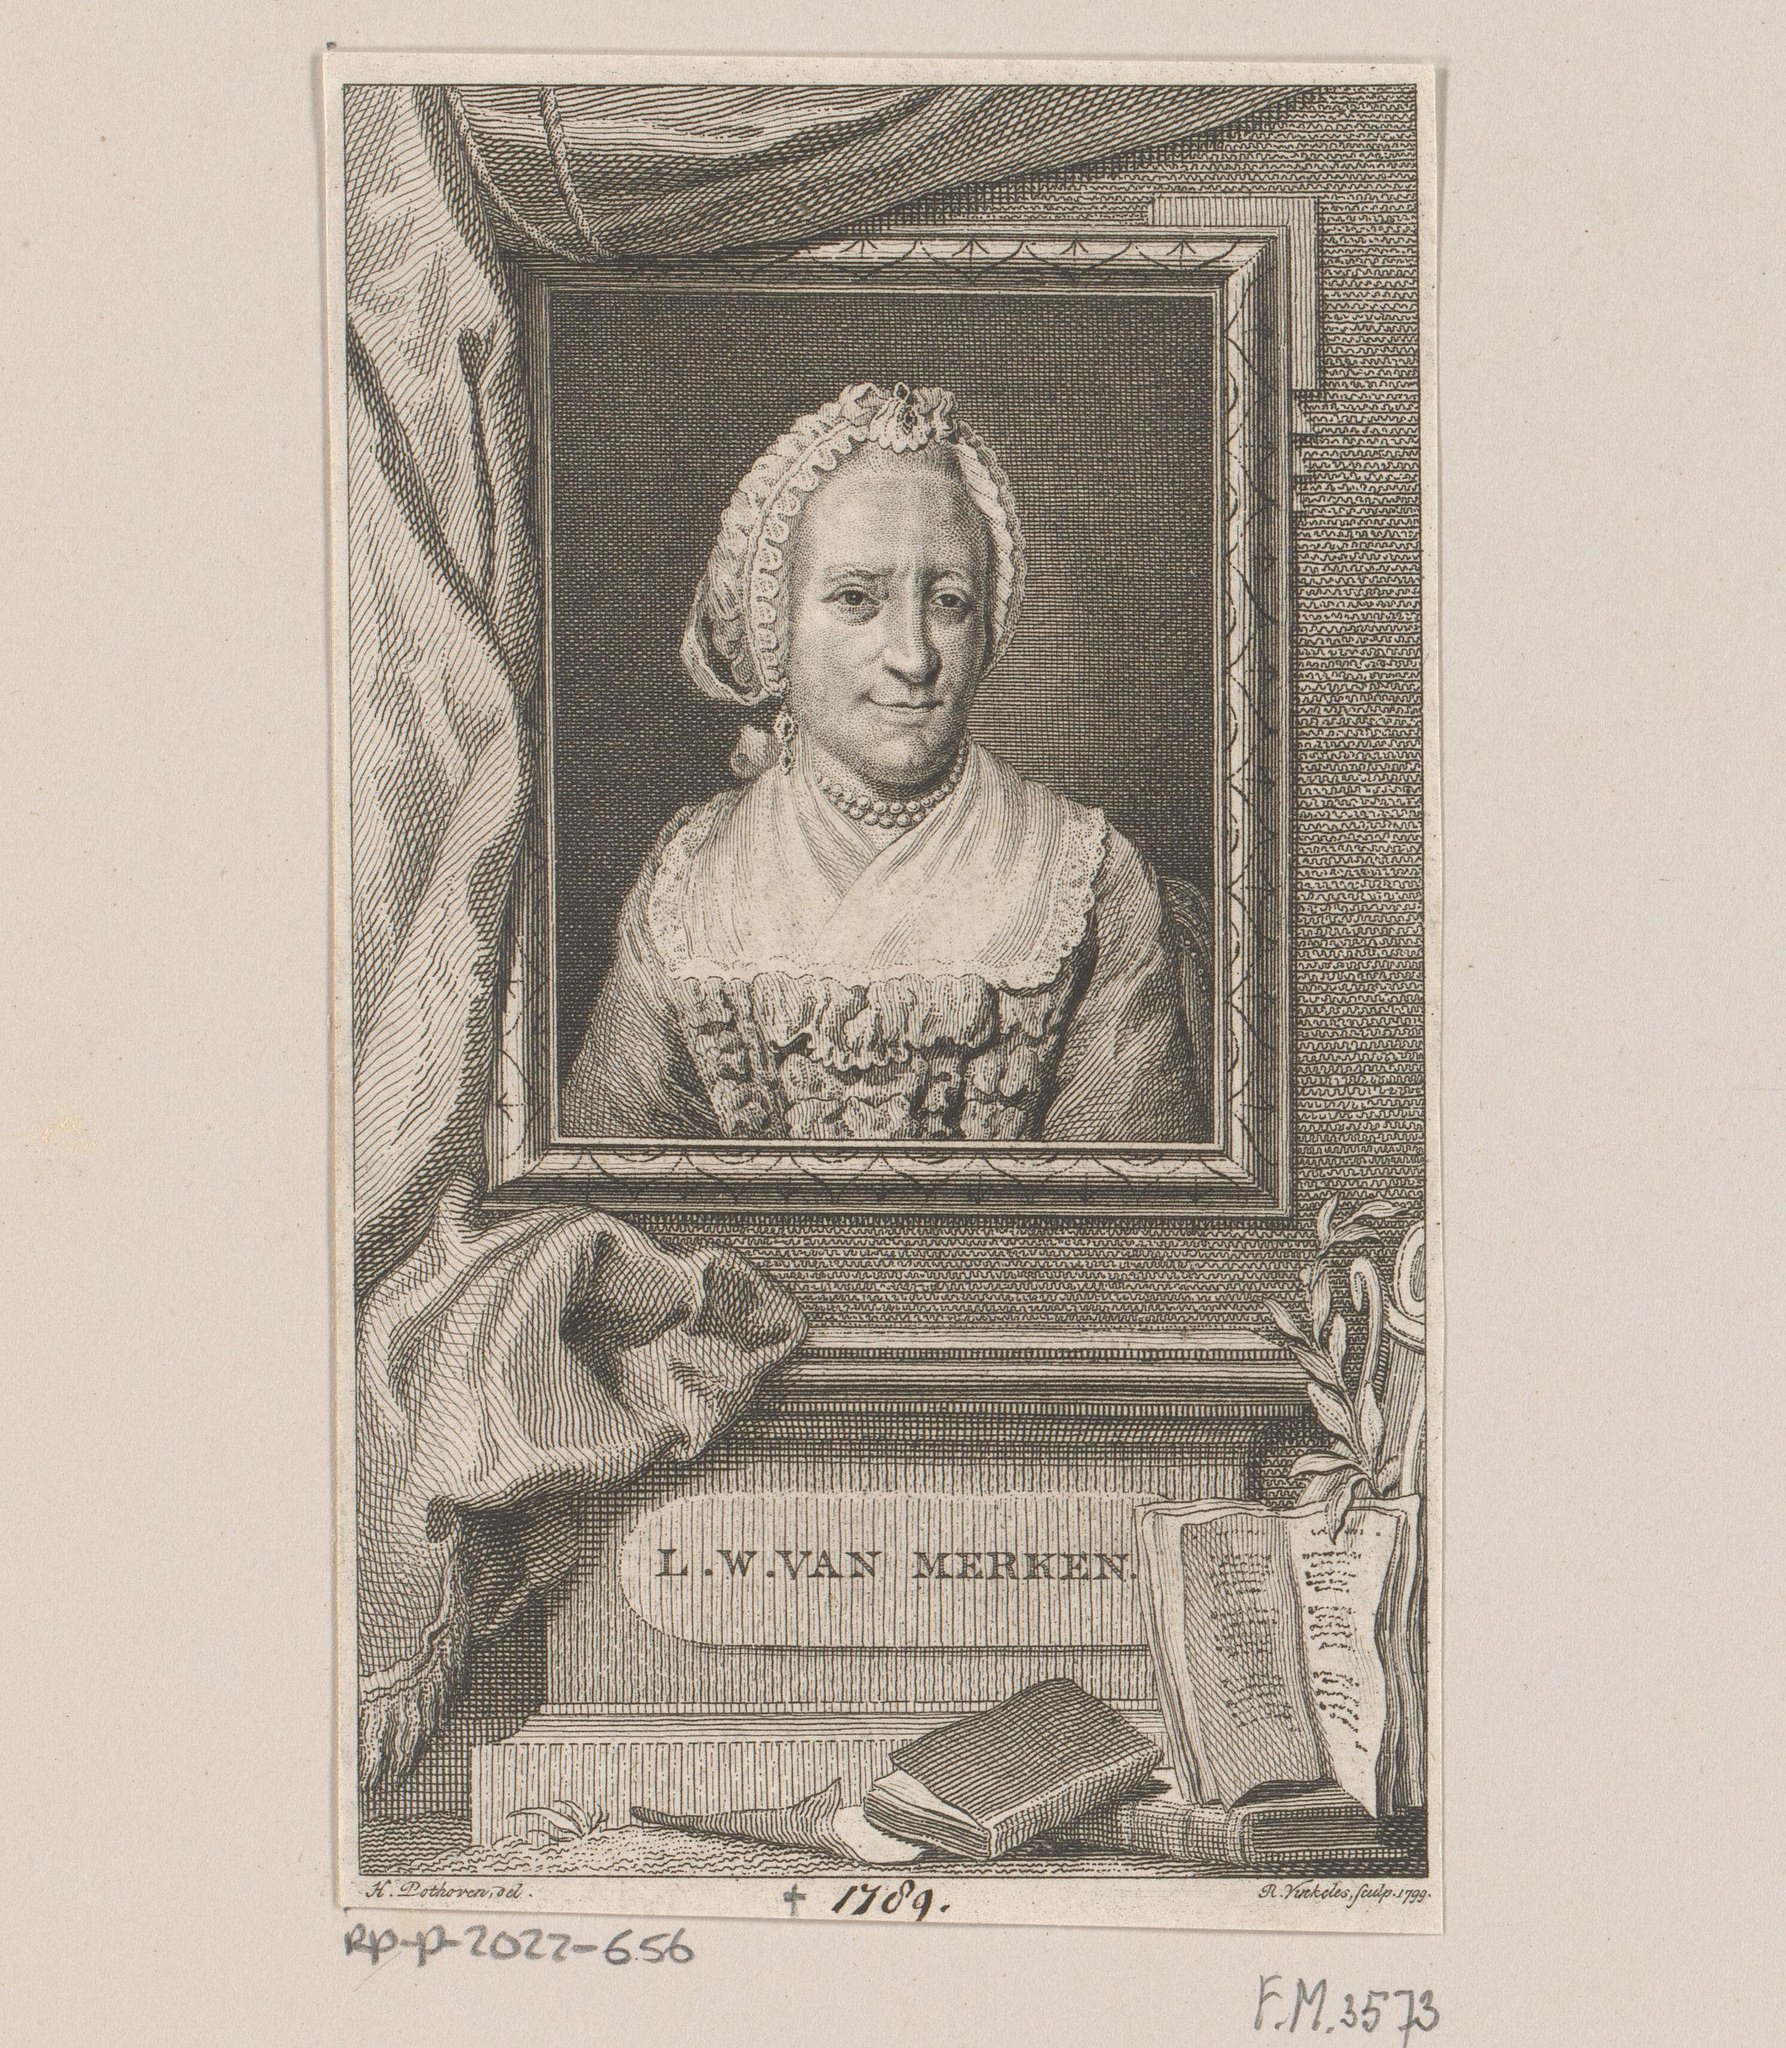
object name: book illustration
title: L.W. van Merken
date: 1799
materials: paper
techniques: etching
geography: amsterdam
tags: lucretia wilhelmina van merken, historical persons - bb - woman, portrait of a writer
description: Prent waarschijnlijk uit: Wagenaar, Jan. Vaderlandsche historie, (...) ten vervolge van Wagenaars Vaderlandsche historie. Amsterdam: Johannes Allart, 1799, dl. 23.